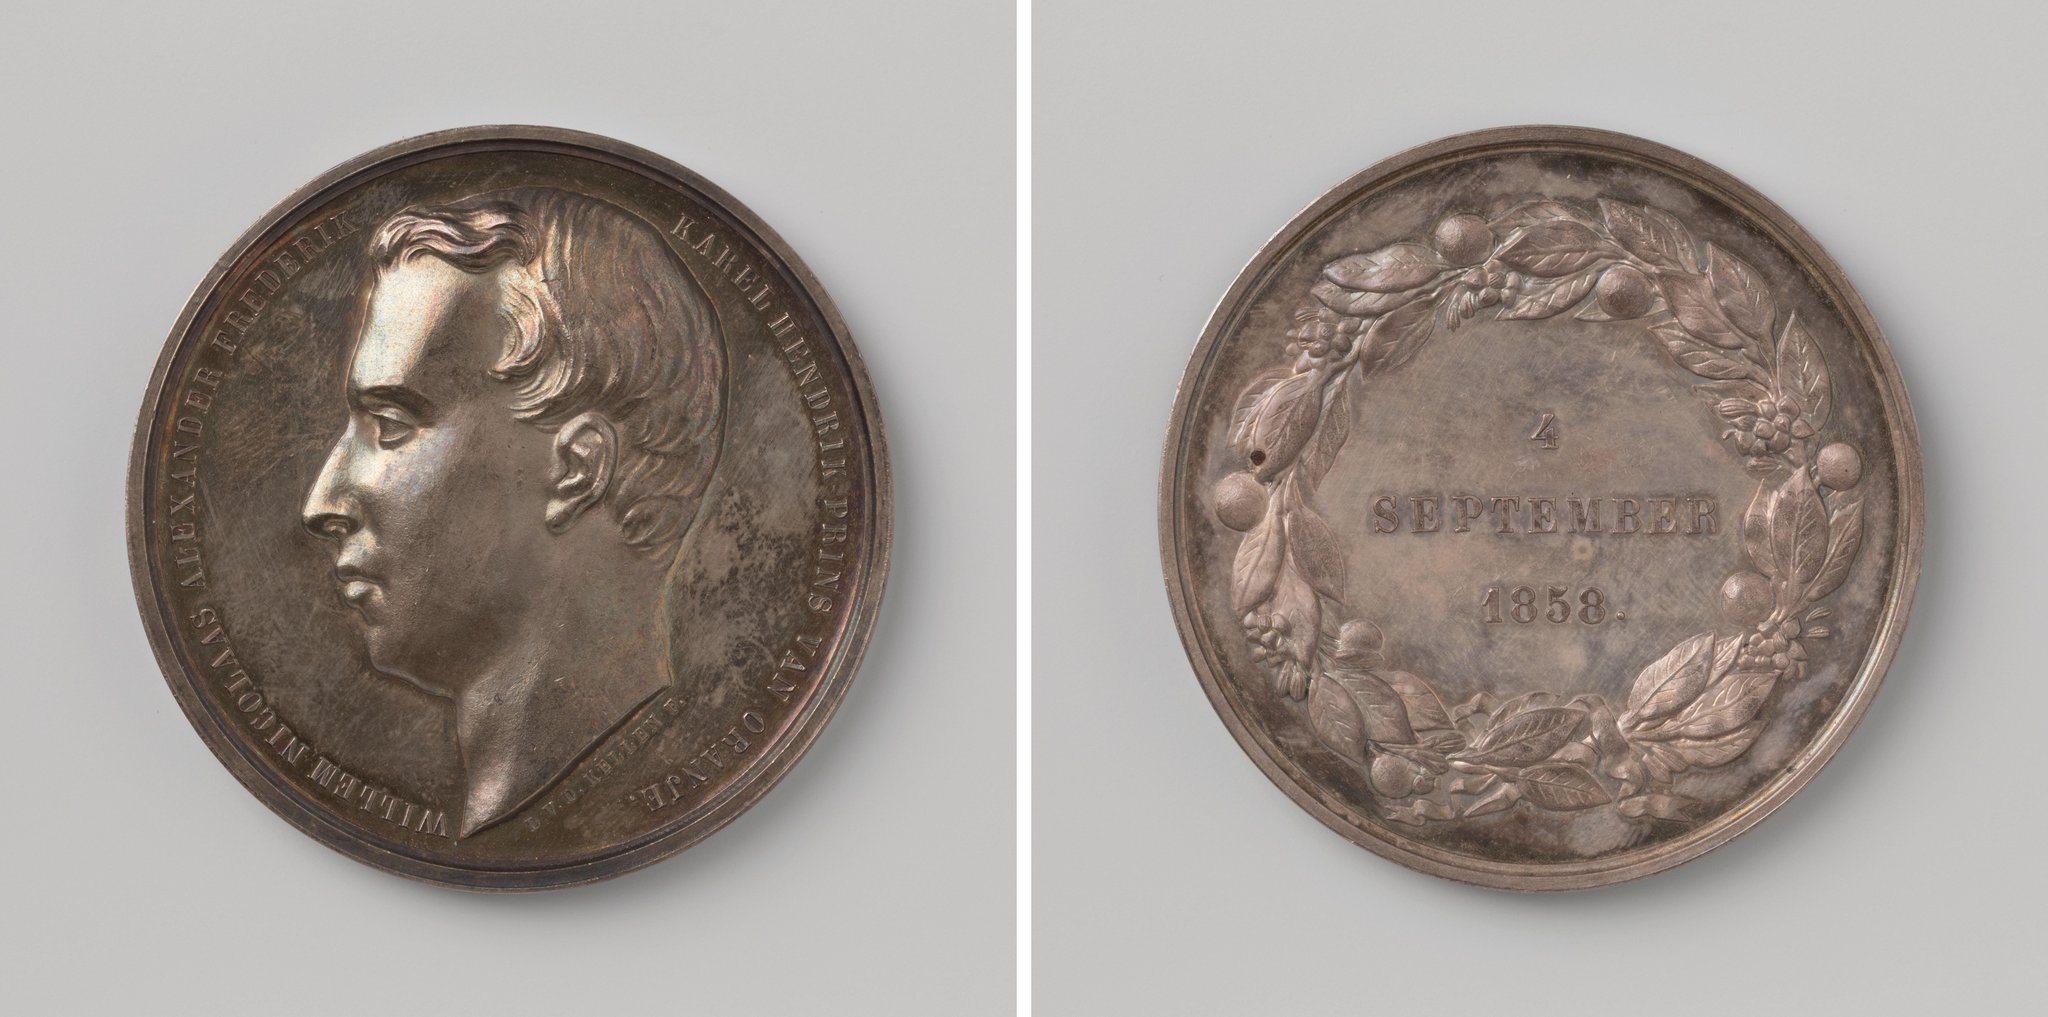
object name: history medal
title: Willem Hendrik Nicolaas Alexander Frederik Carel, erfprins der Nederlanden bereikt de meerderjarigheid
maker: david van der kellen (1804-1879)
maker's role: die cutter, draughtsman, print maker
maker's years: 1804-1879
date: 1858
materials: silver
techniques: striking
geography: utrecht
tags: the hague, paris, willem (prins der nederlanden)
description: Zilveren penning. Voorzijde: borststuk man binnen omschrift. Keerzijde: datum binnen krans van oranjetakken